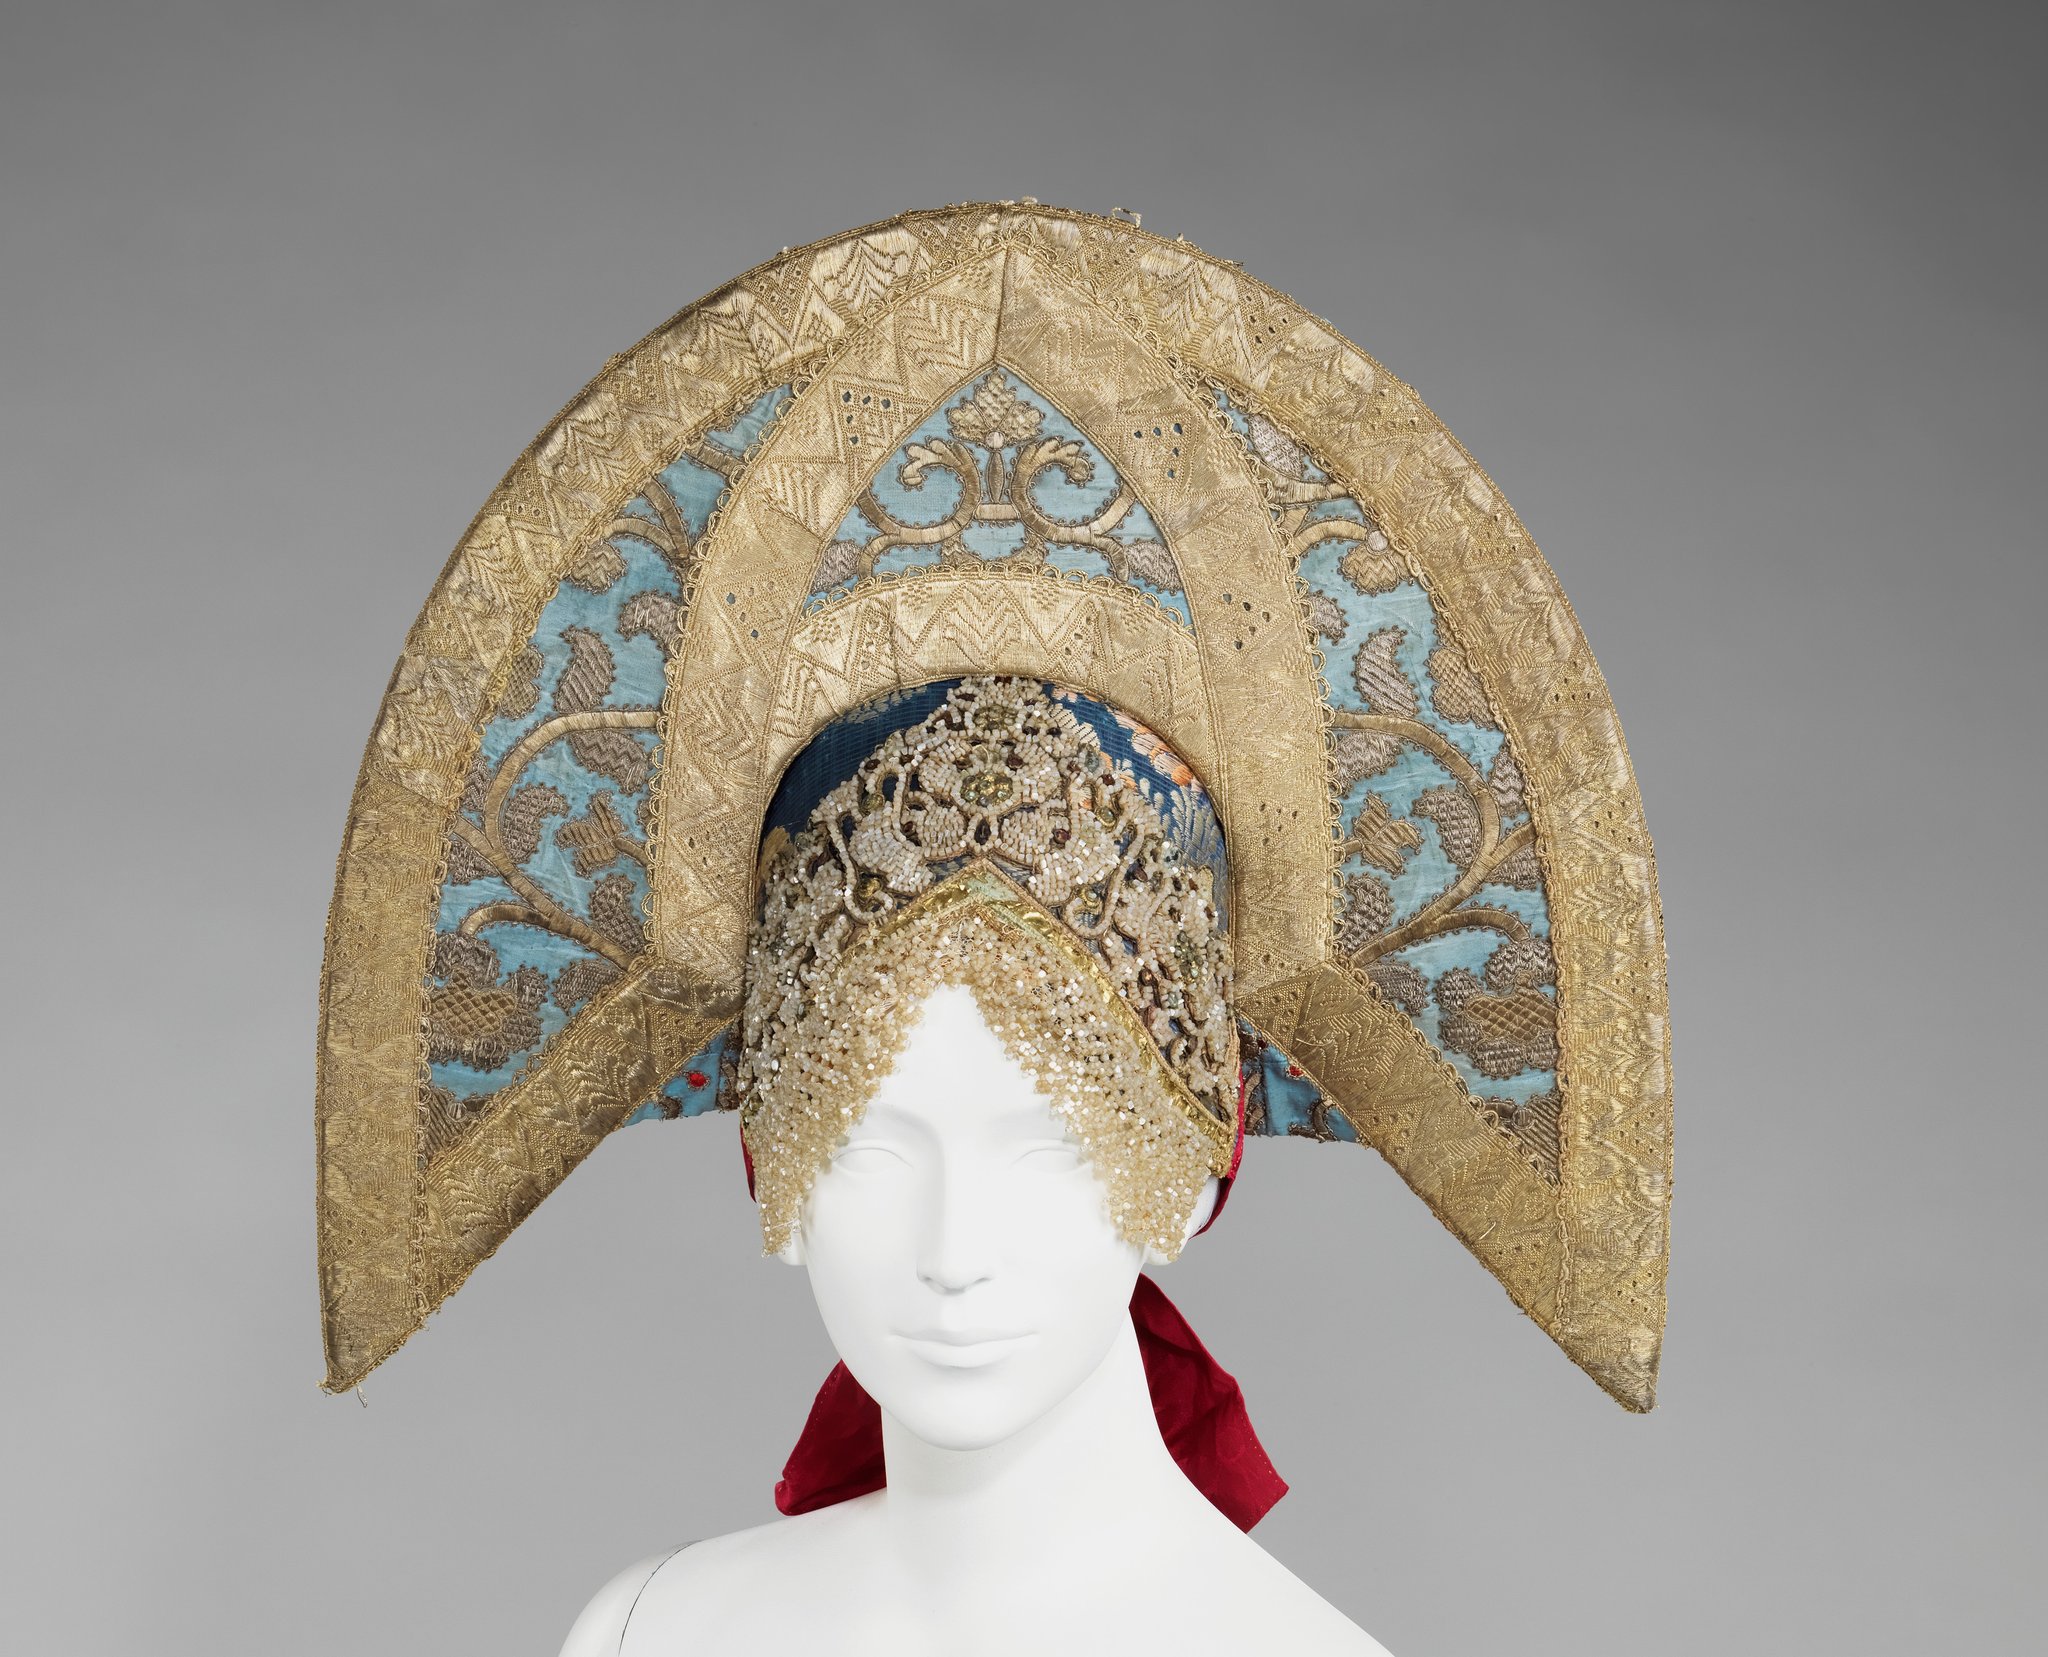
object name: headdress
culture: russian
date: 1801-1833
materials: cotton, metal, paper, silk